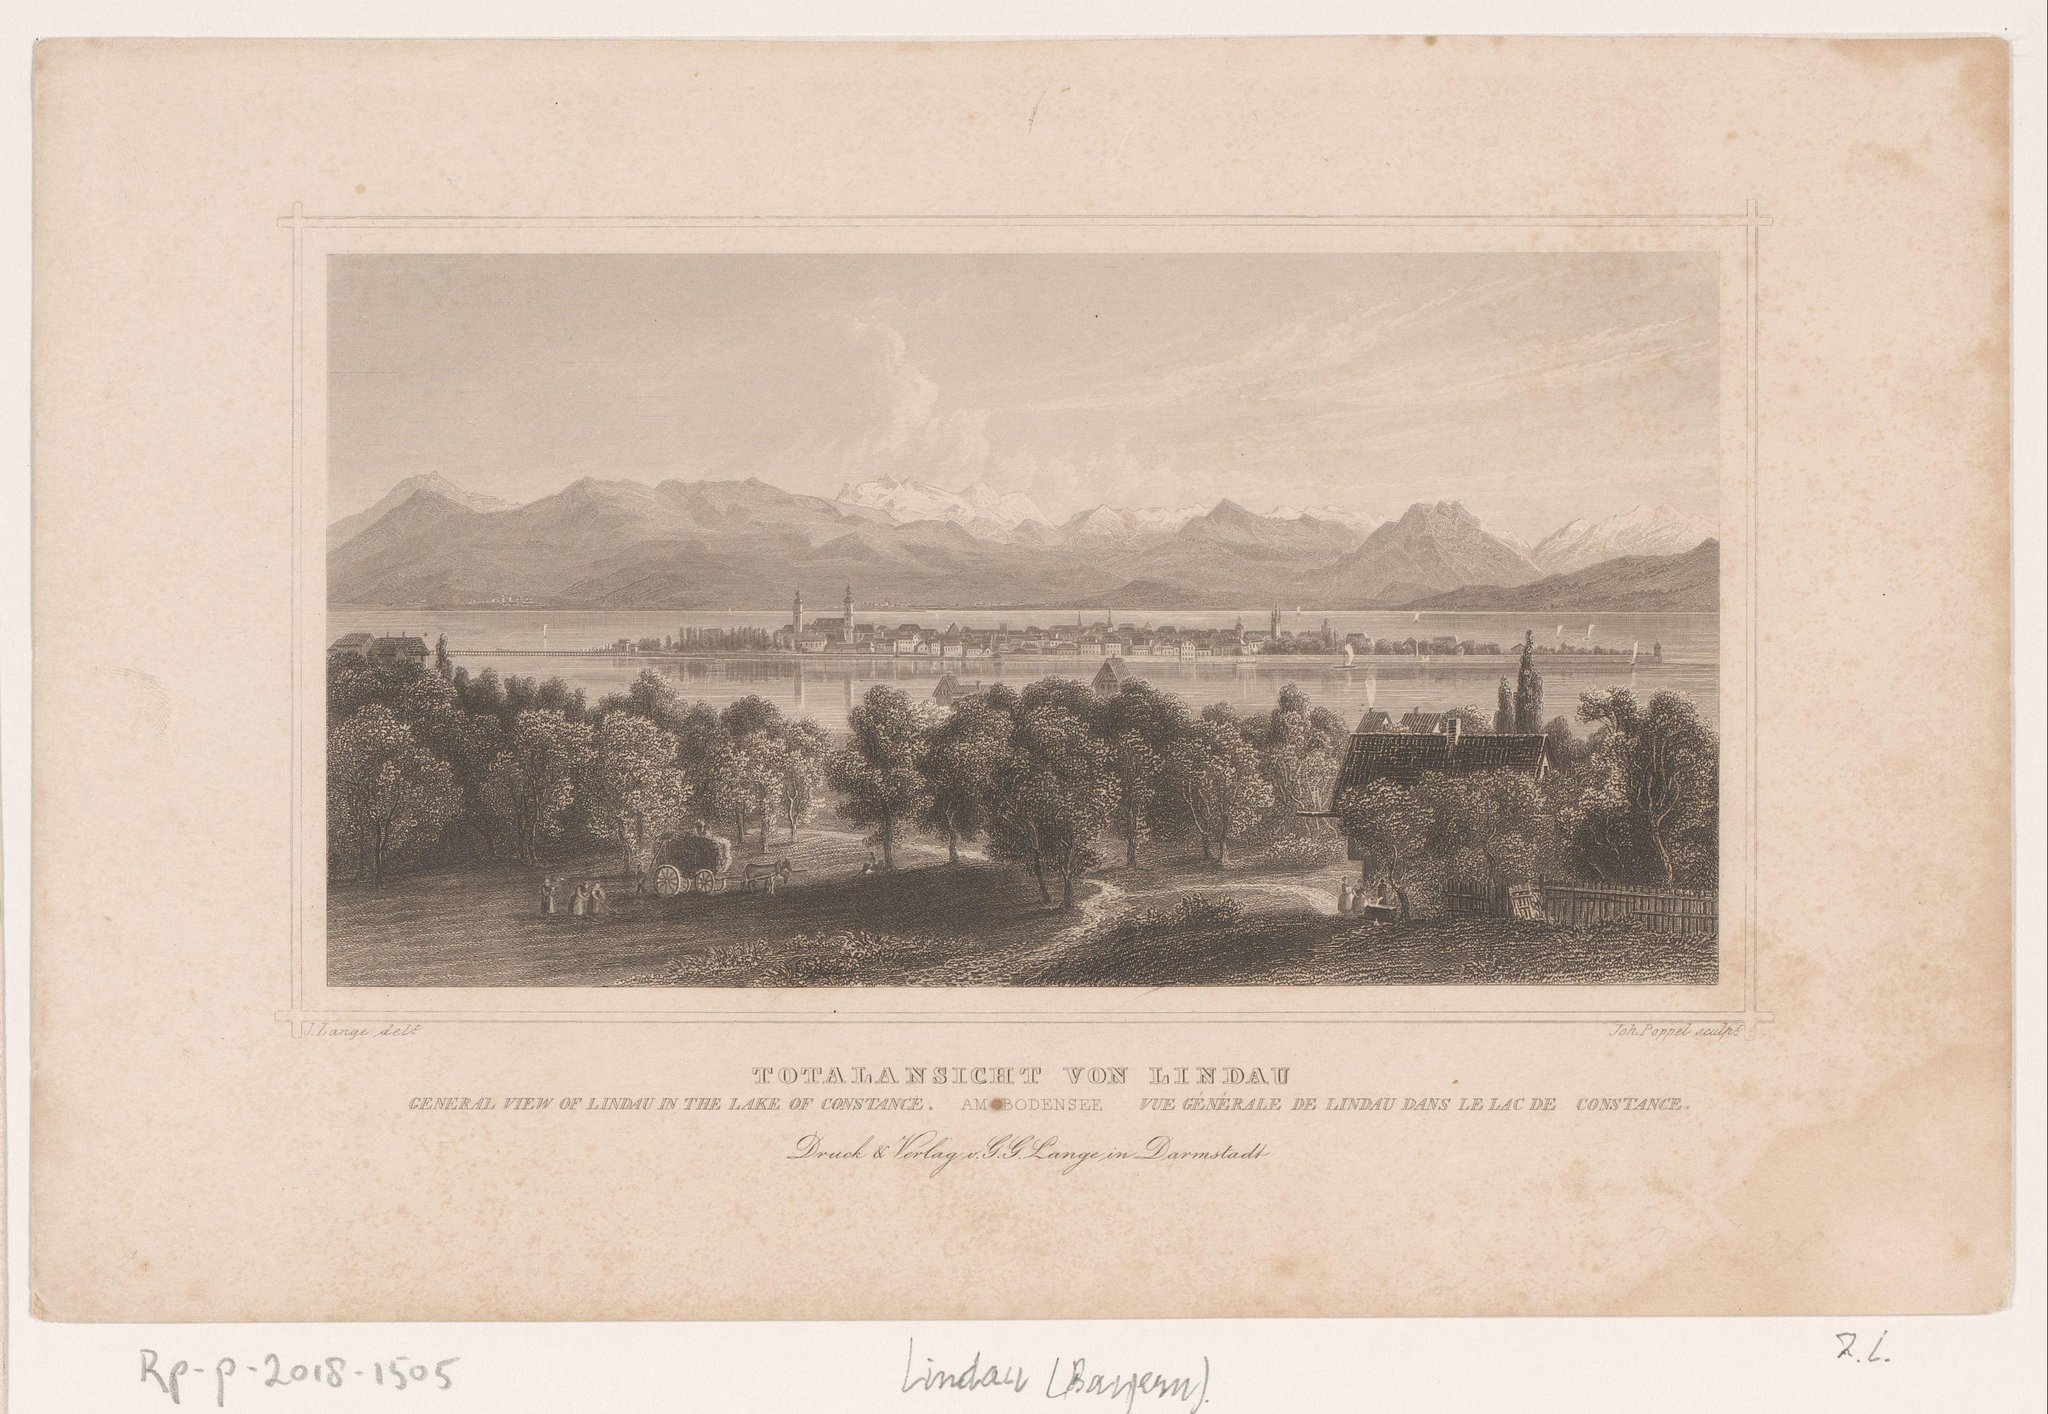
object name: print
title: Totalansicht von Lindau / General view of Lindau in the Lake of Constance. Am Bodensee / Vue générale de Lindau dans le Lac de Constance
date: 1831-1843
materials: paper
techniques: engraving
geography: darmstadt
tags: lake, prospect of city, town panorama, silhouette of city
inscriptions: collector's mark: Lugt 2228